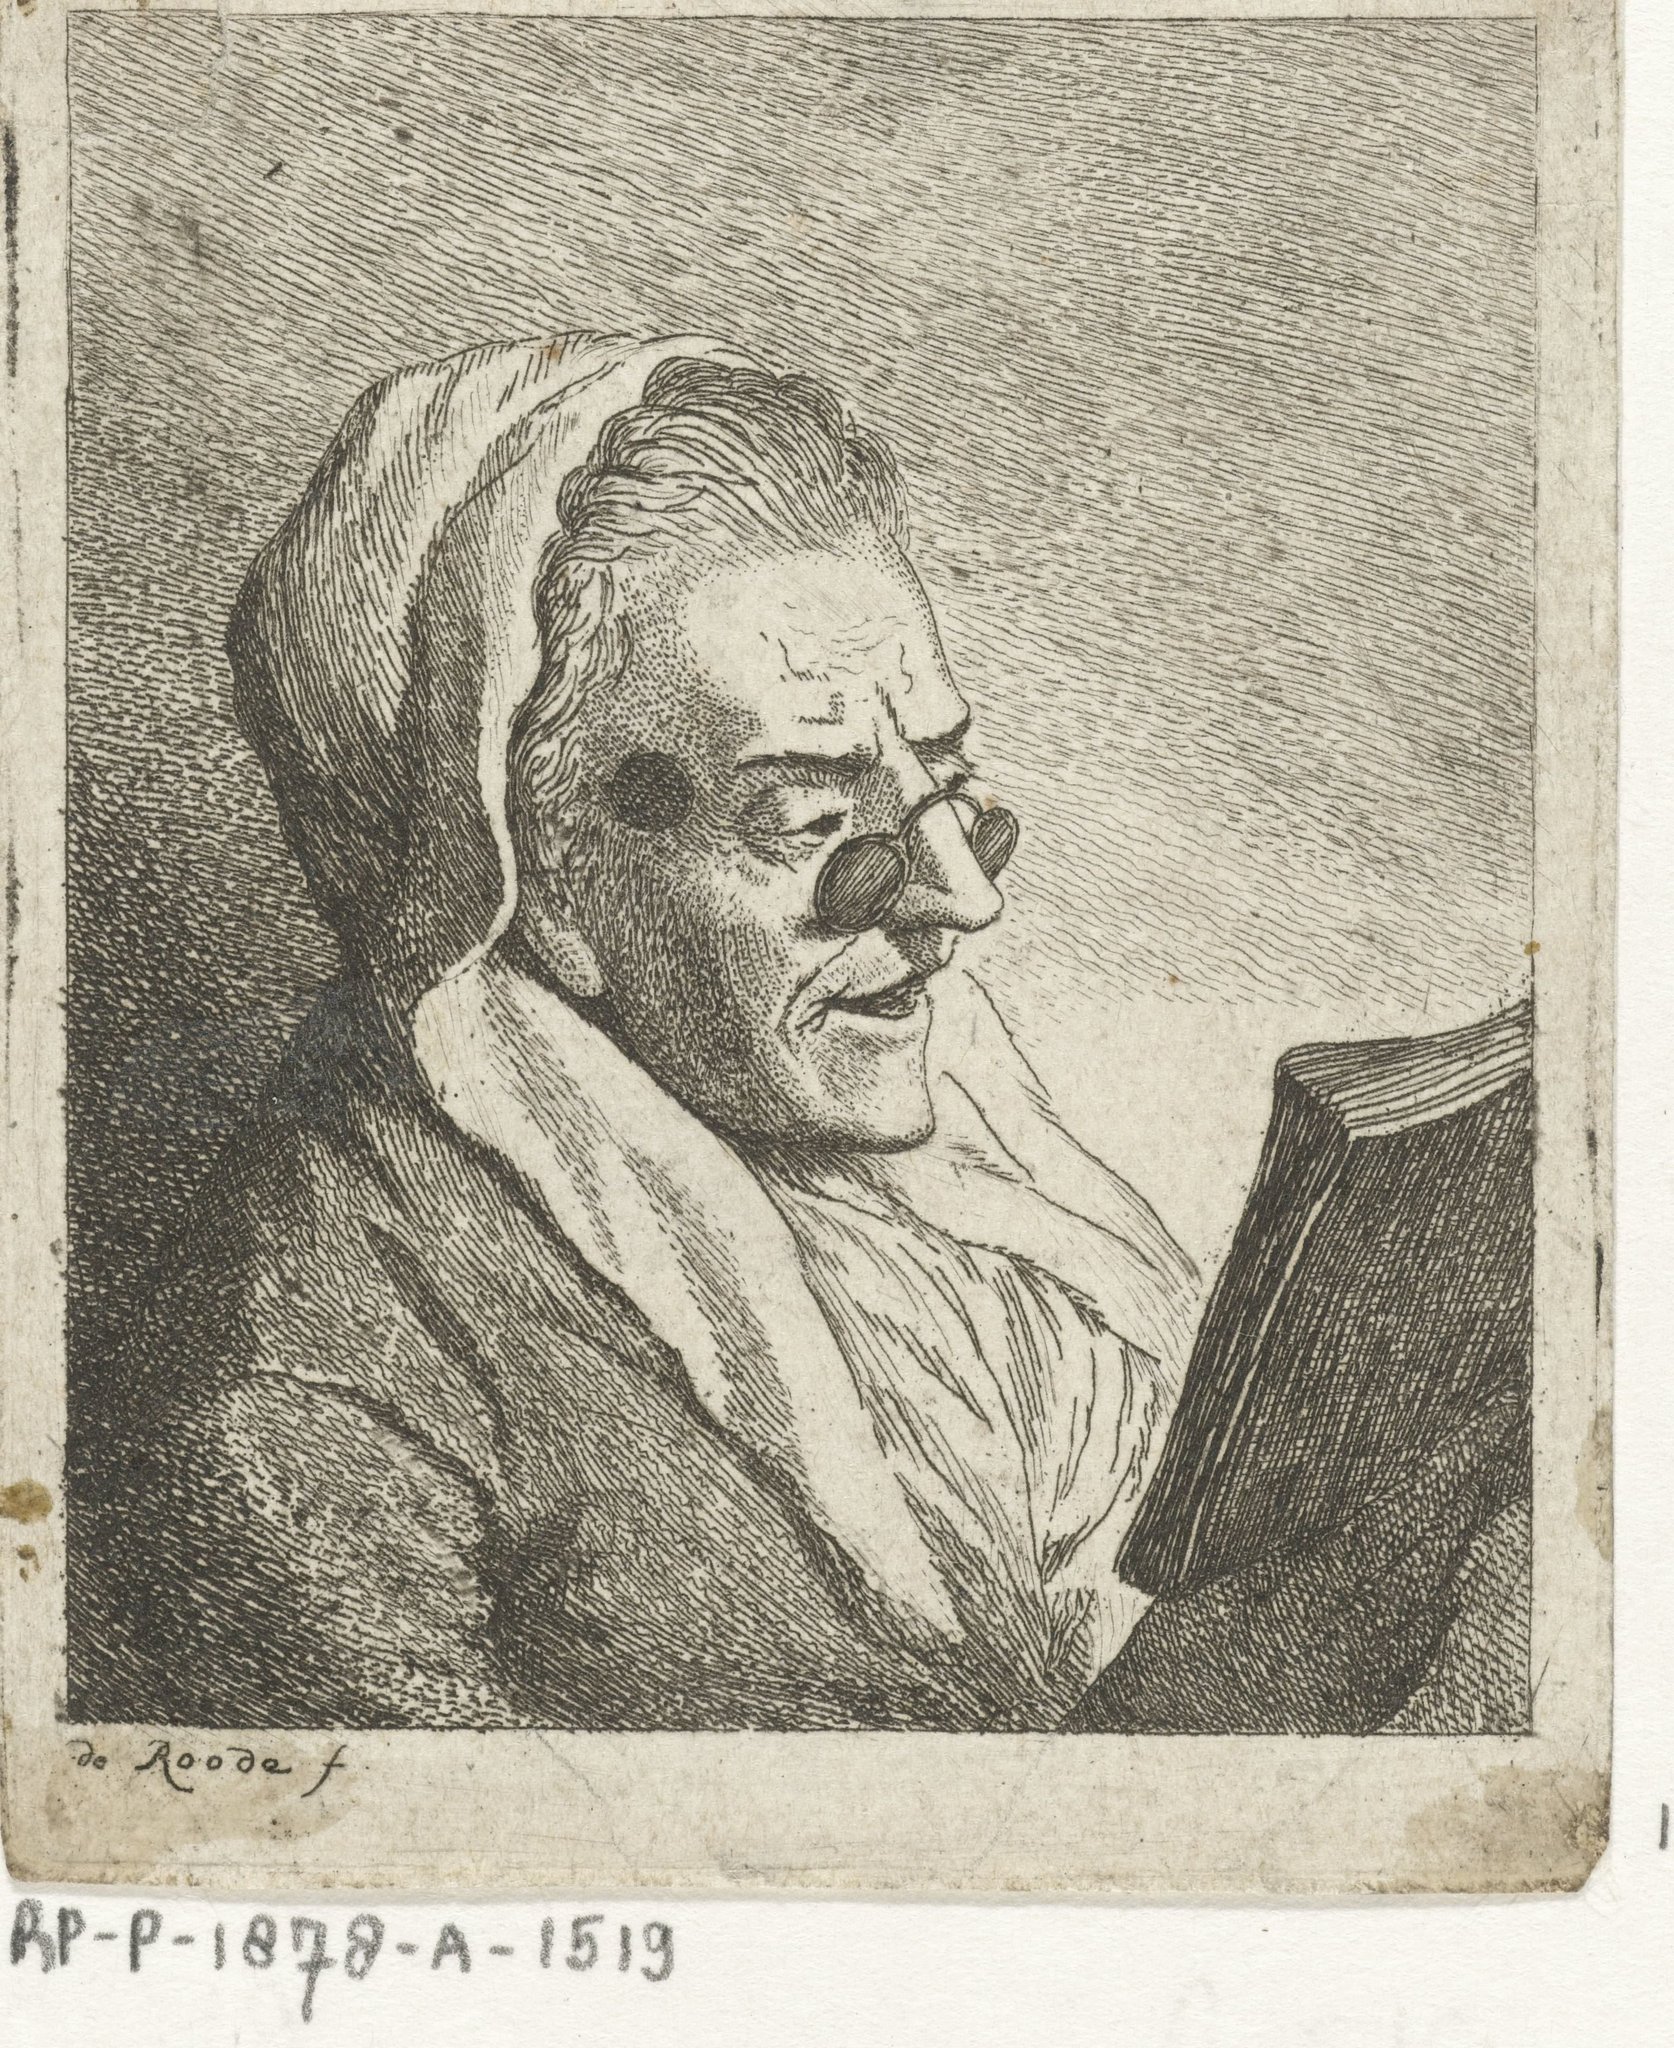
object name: print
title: Lezende oude vrouw met knijpbril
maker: theodorus de roode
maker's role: draughtsman, print maker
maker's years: 1736-1793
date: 1746-1793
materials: paper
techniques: etching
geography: netherlands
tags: eyeglasses, spectacles, reading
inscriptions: collector's mark: Lugt 2228